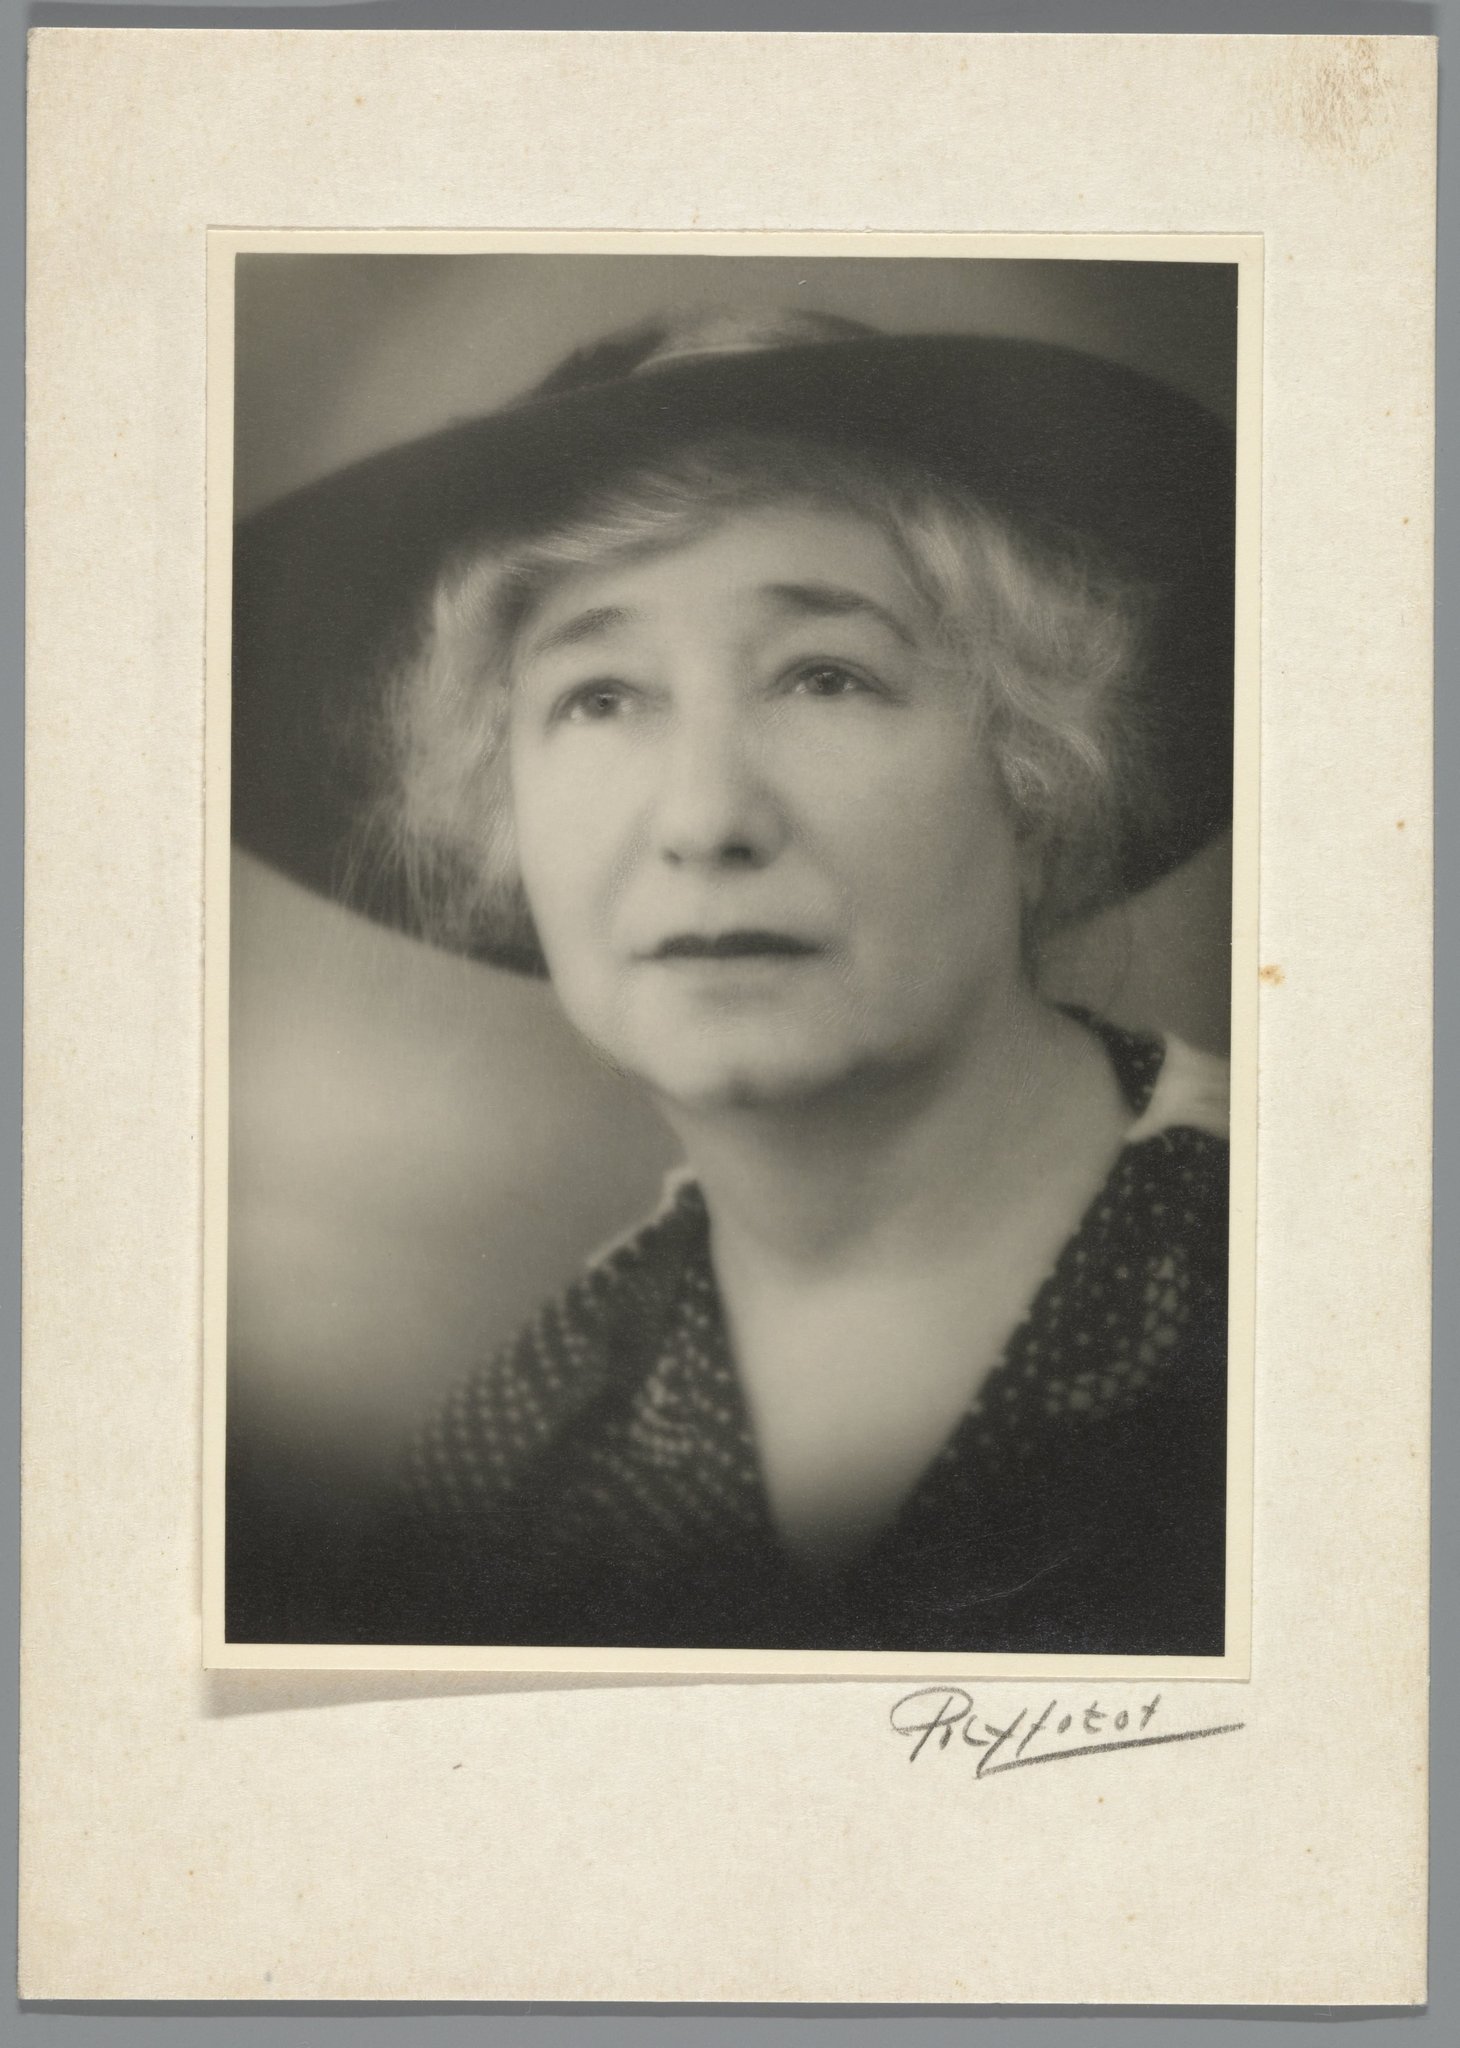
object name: photograph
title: Marie Witsen-Schorr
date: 1860-1915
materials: paper, photographic support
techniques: gelatin silver print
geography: netherlands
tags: amsterdam, augusta maria agnes witsen-schorr